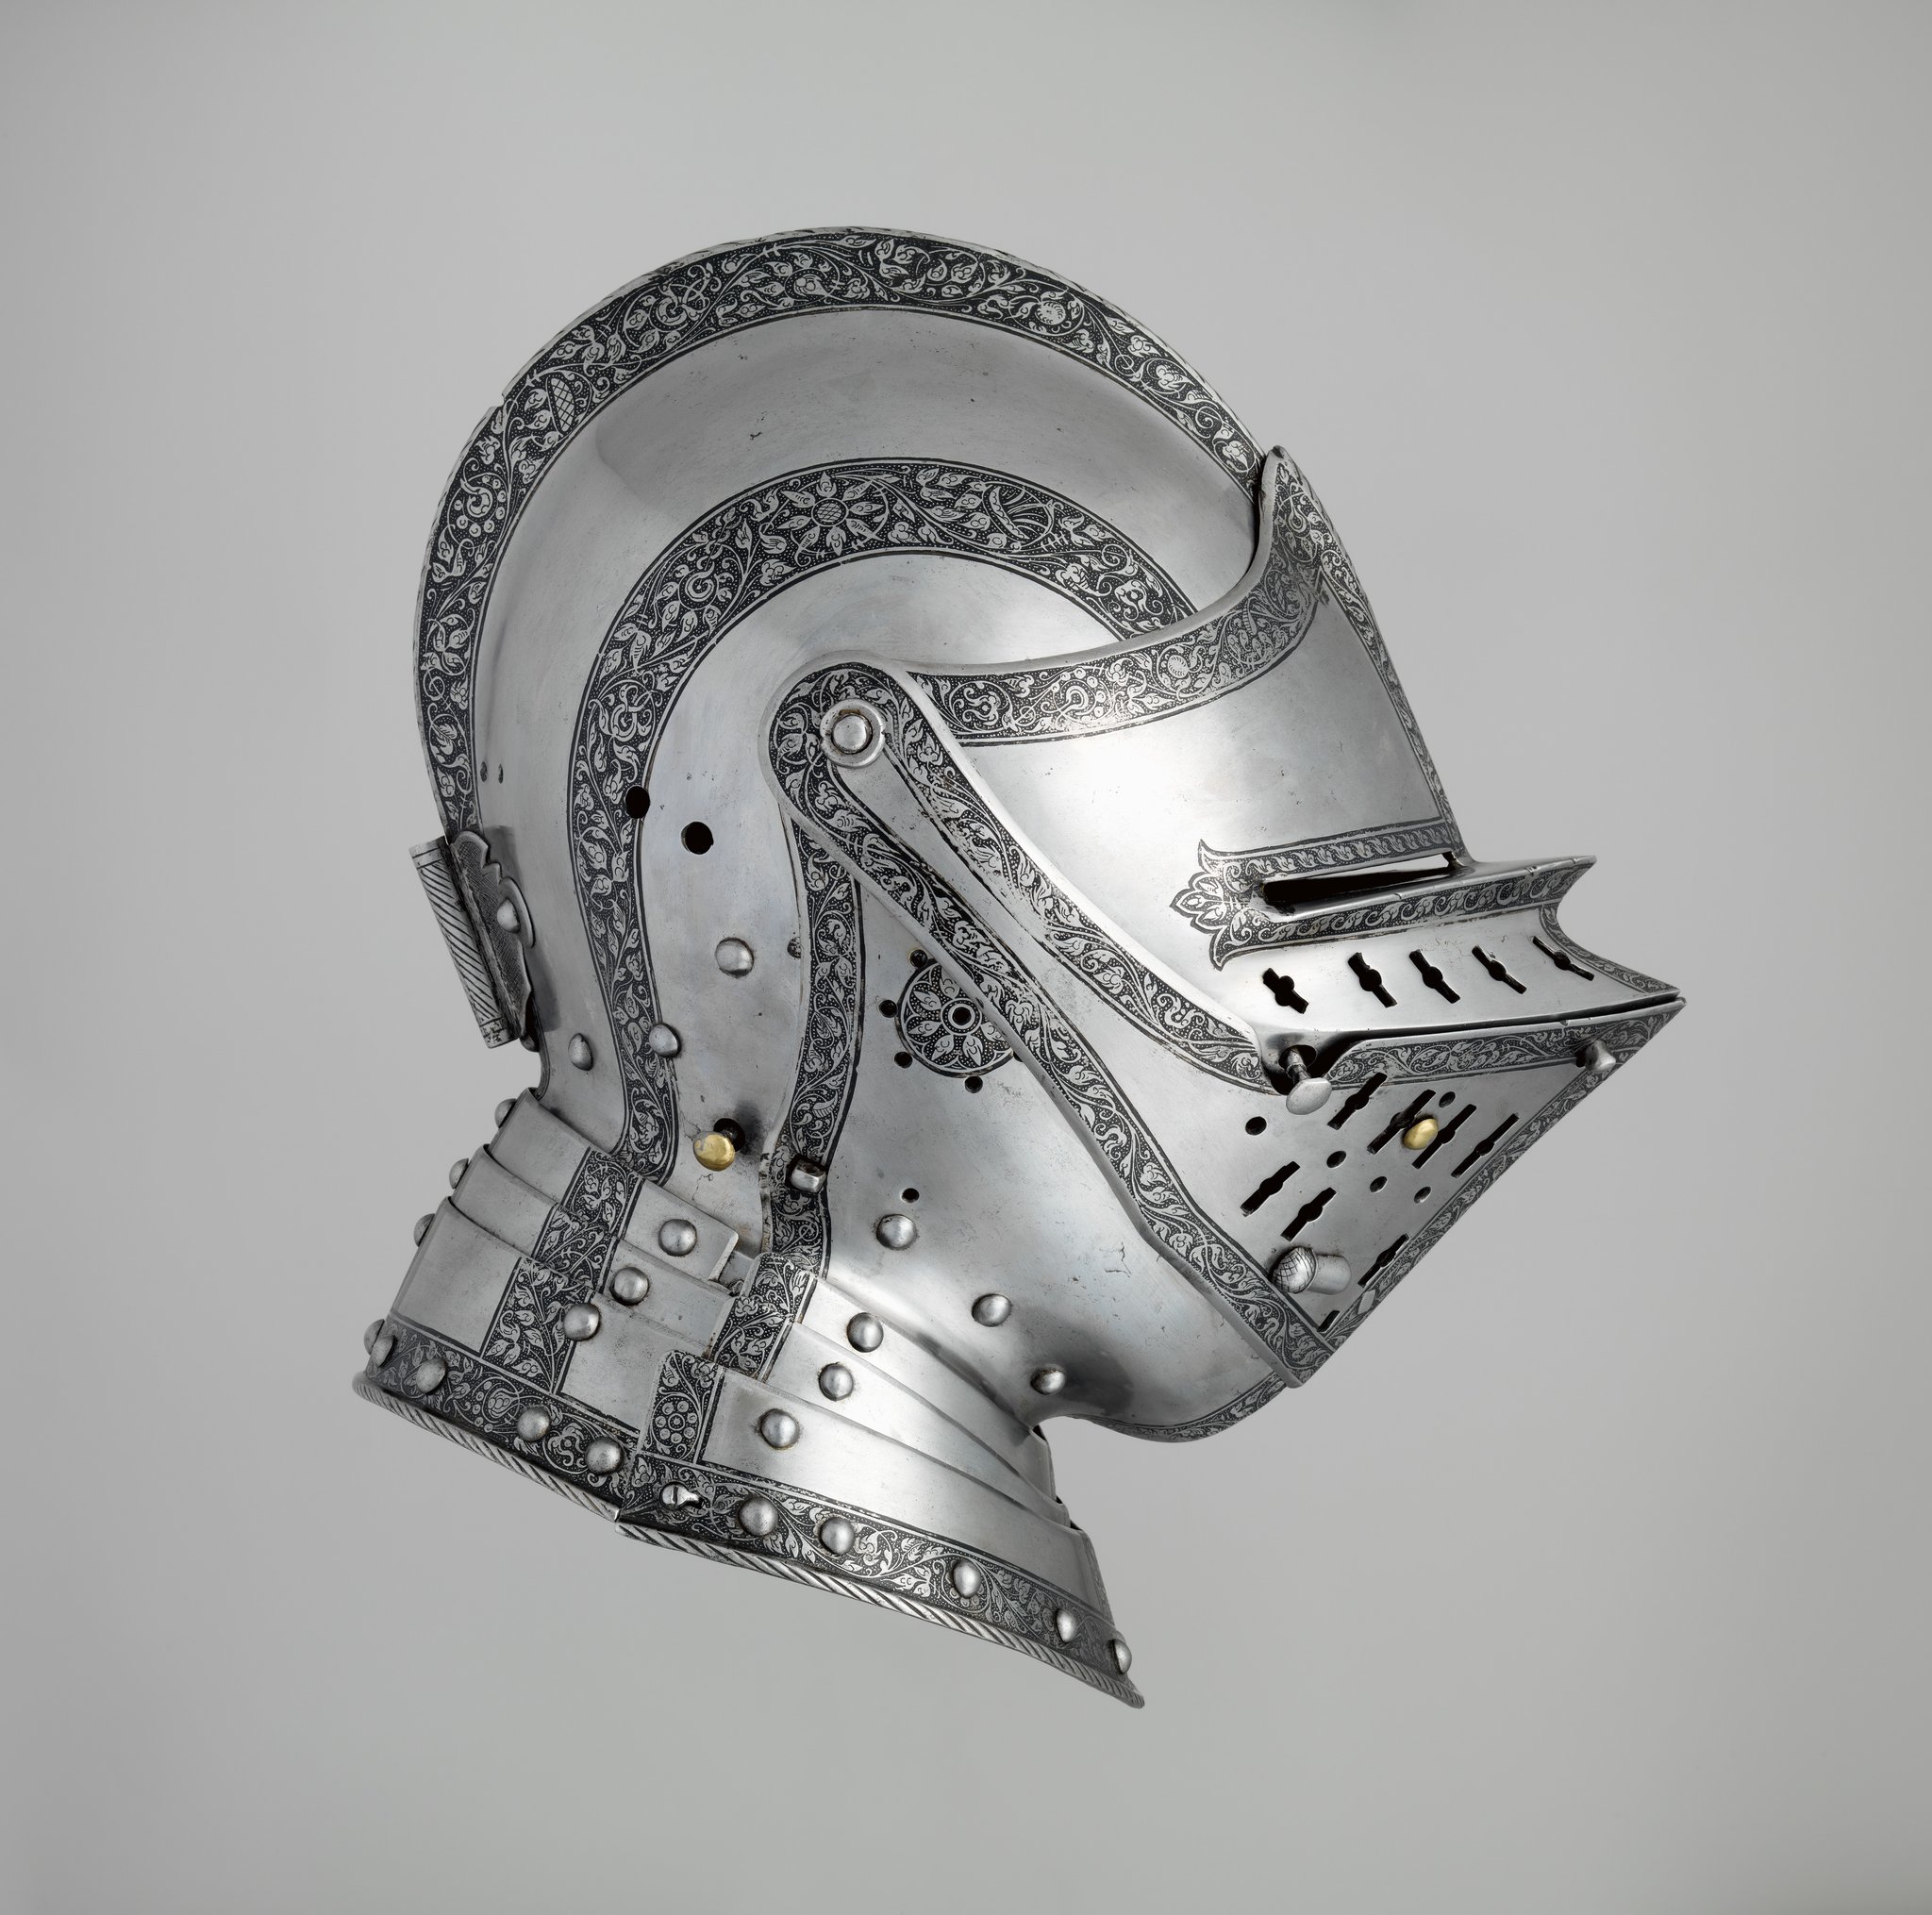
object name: close helmet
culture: german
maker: wolfgang grosschedel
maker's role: armorer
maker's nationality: german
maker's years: 1517-1562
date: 1560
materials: copper alloy, leather, steel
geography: germany